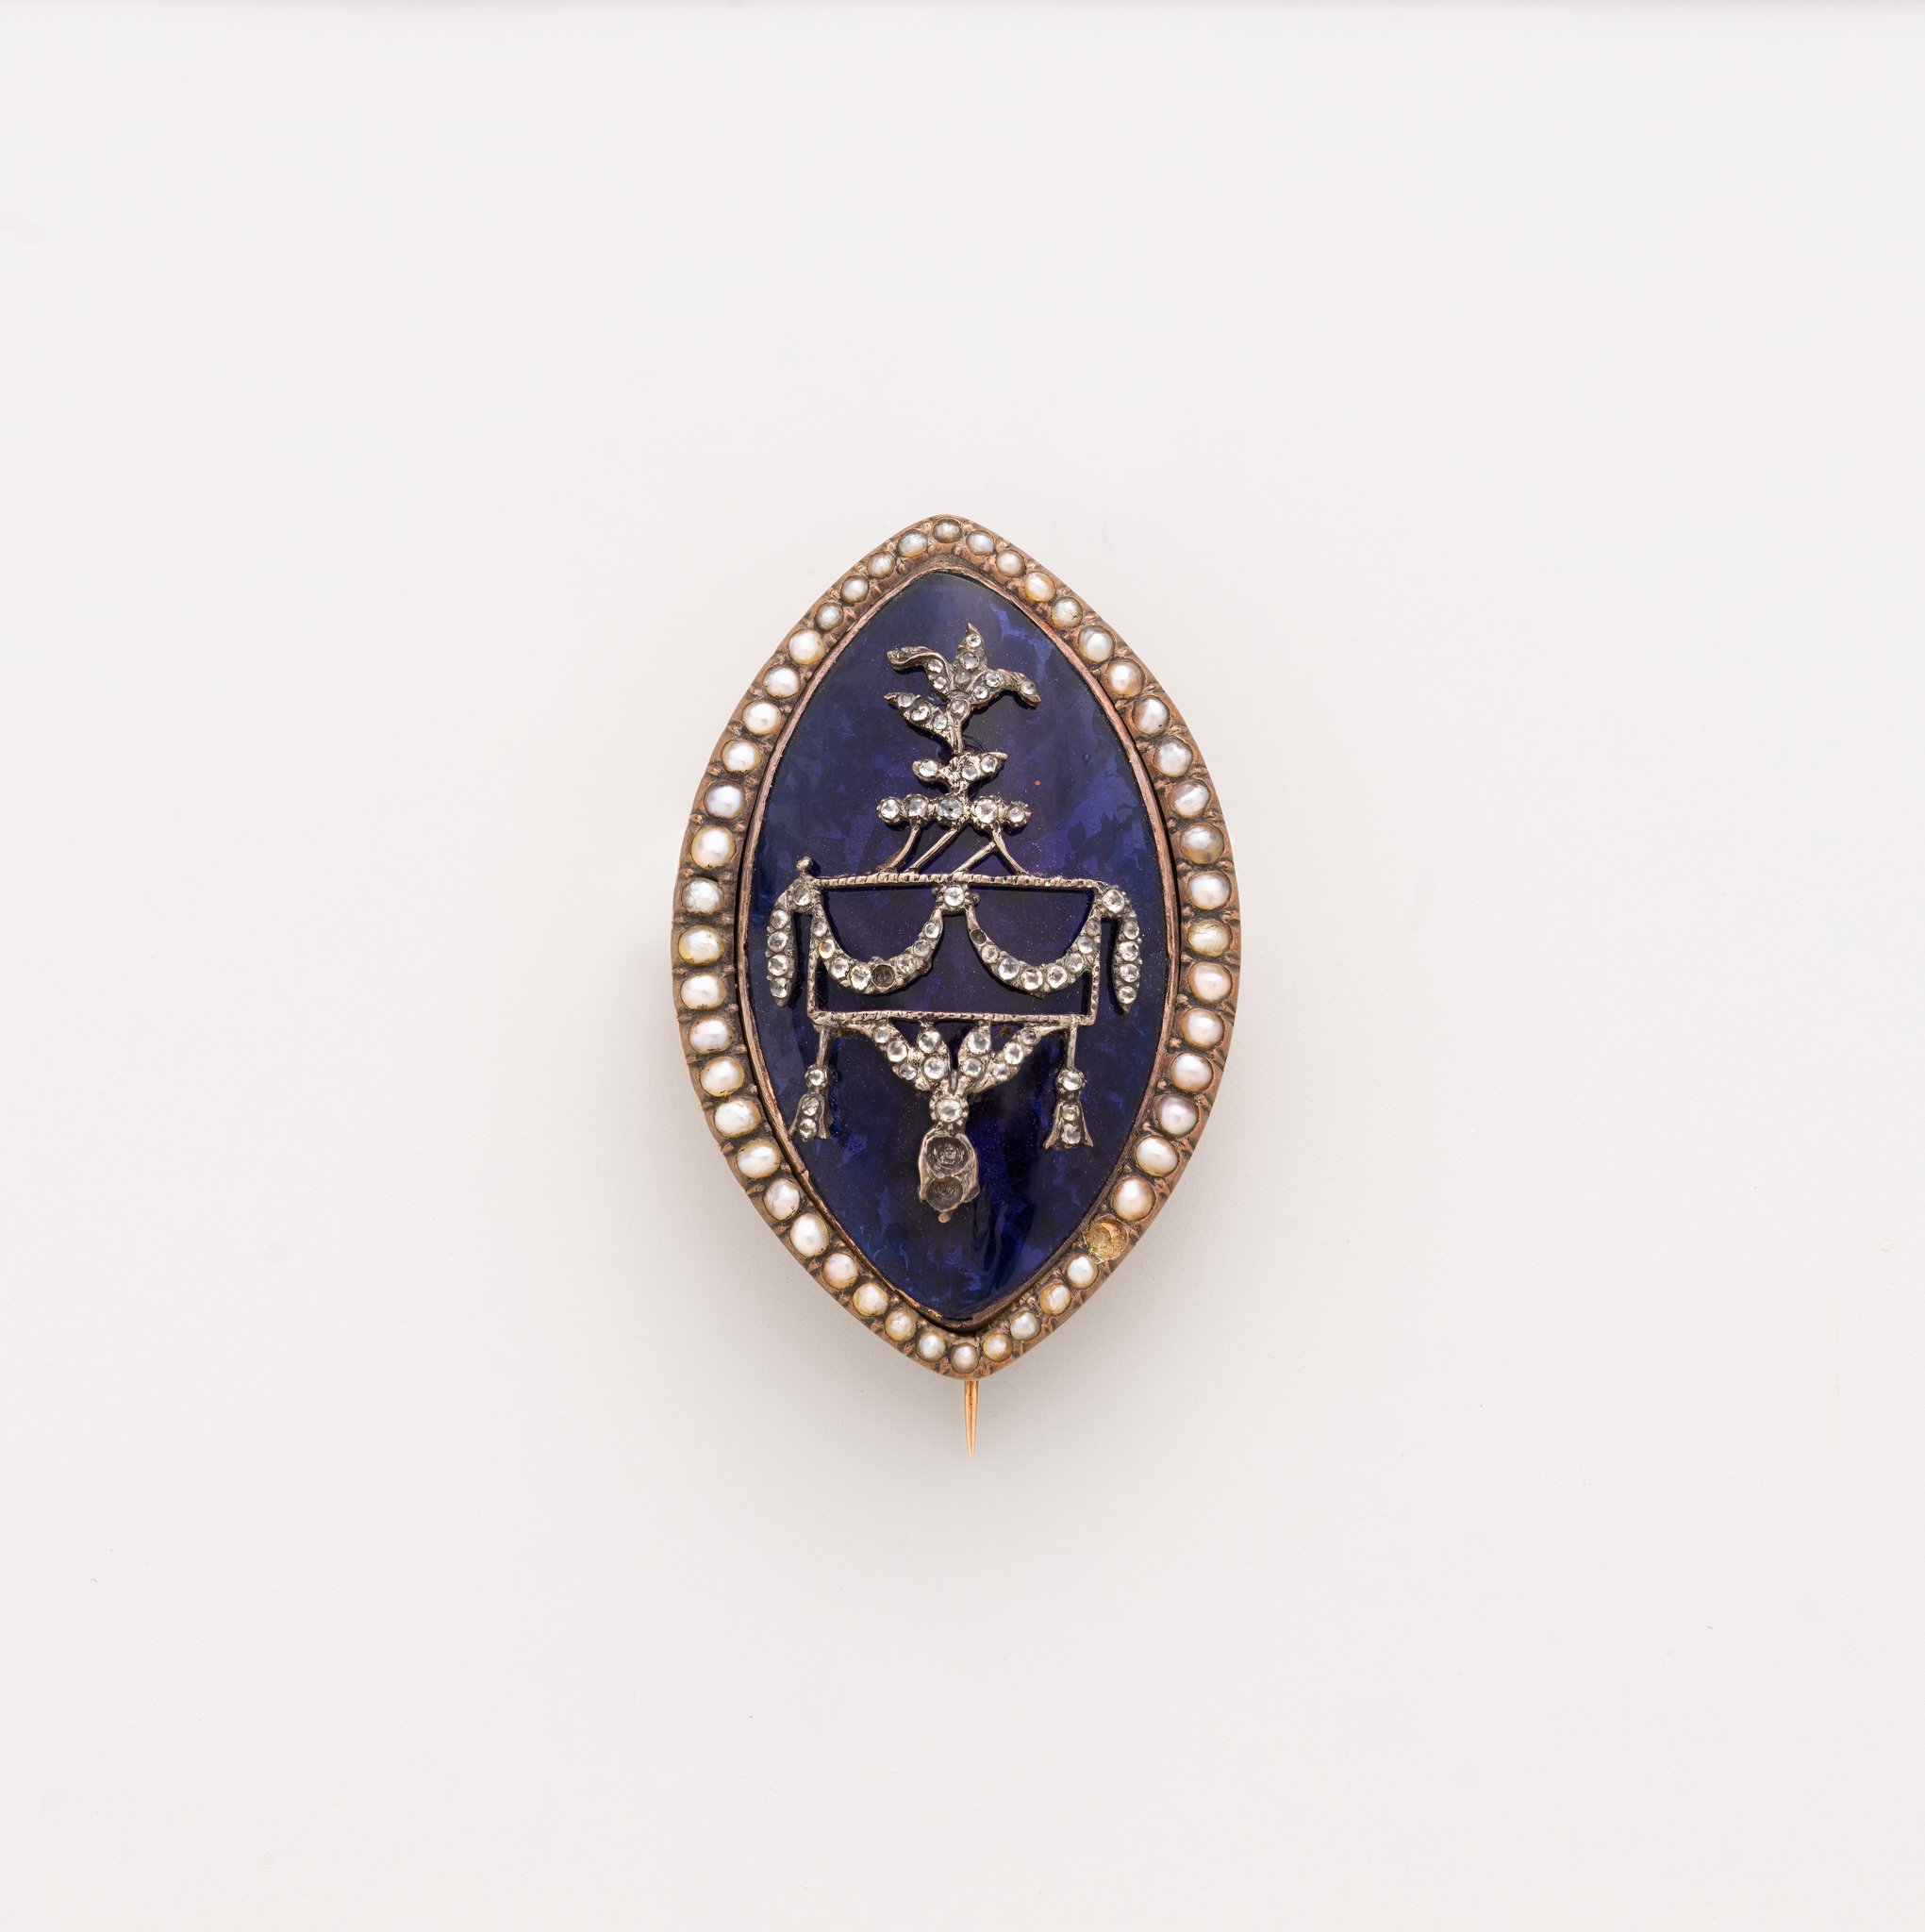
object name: brooch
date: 1767-1800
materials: gold, pearl